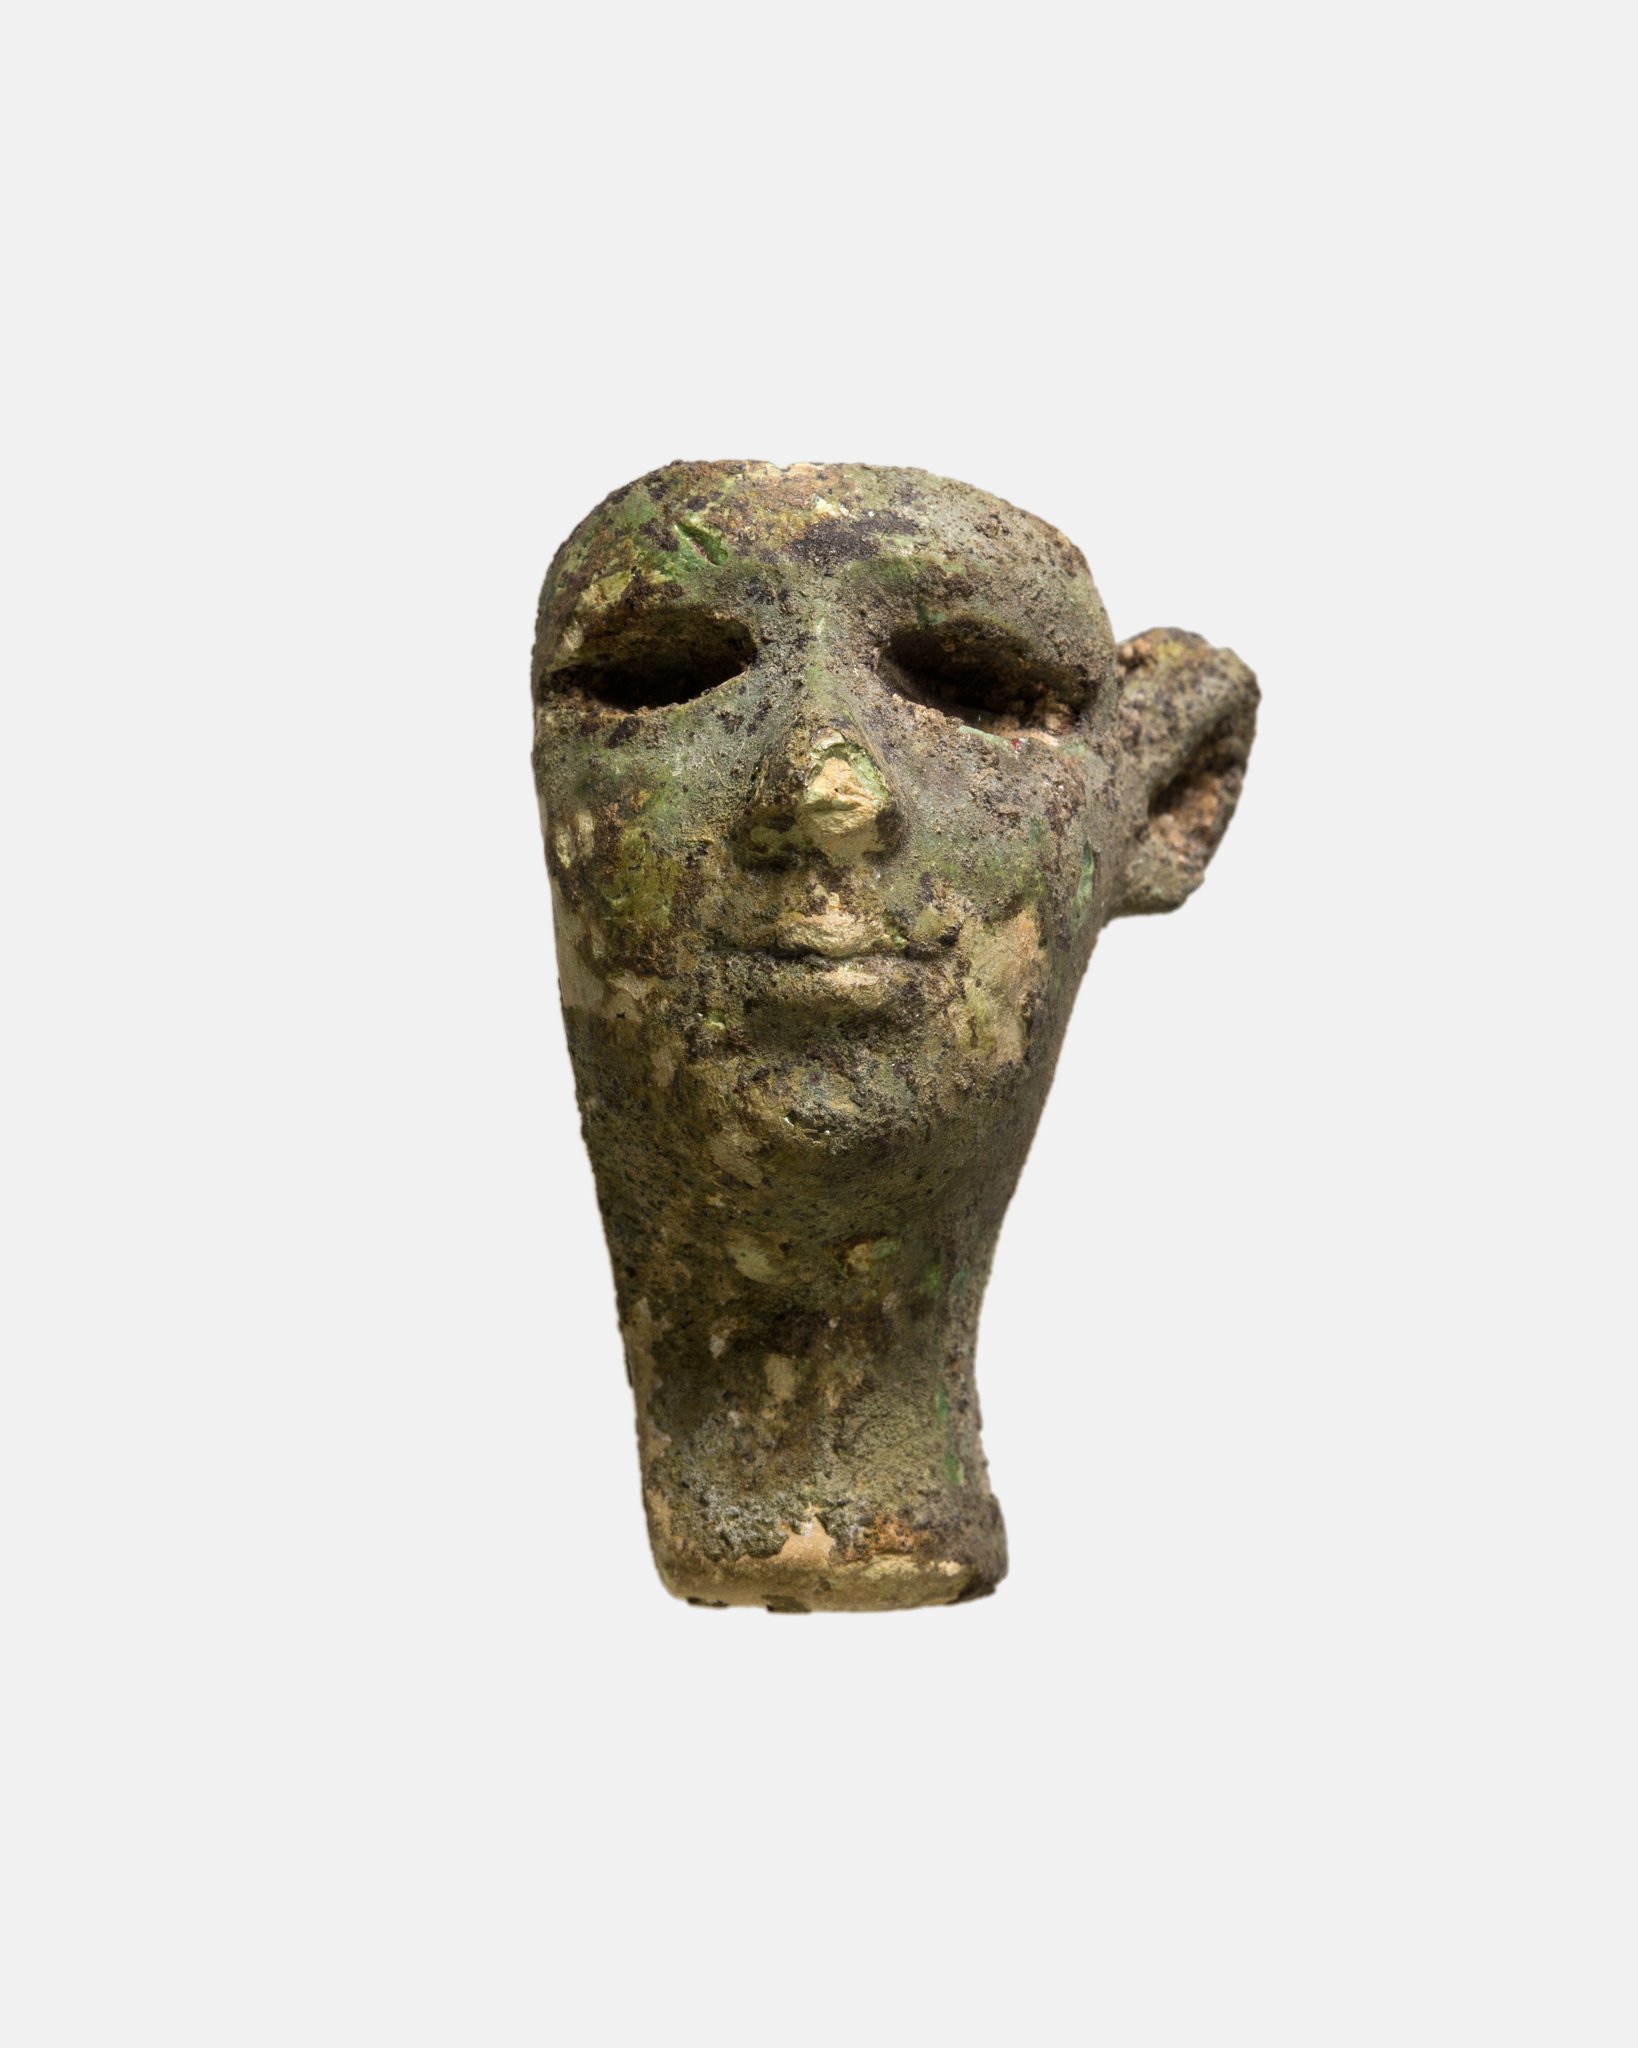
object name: insert, man's head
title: Male (originally red) head for composite statuette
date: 664-630 BCE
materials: glass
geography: egypt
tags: heads,men